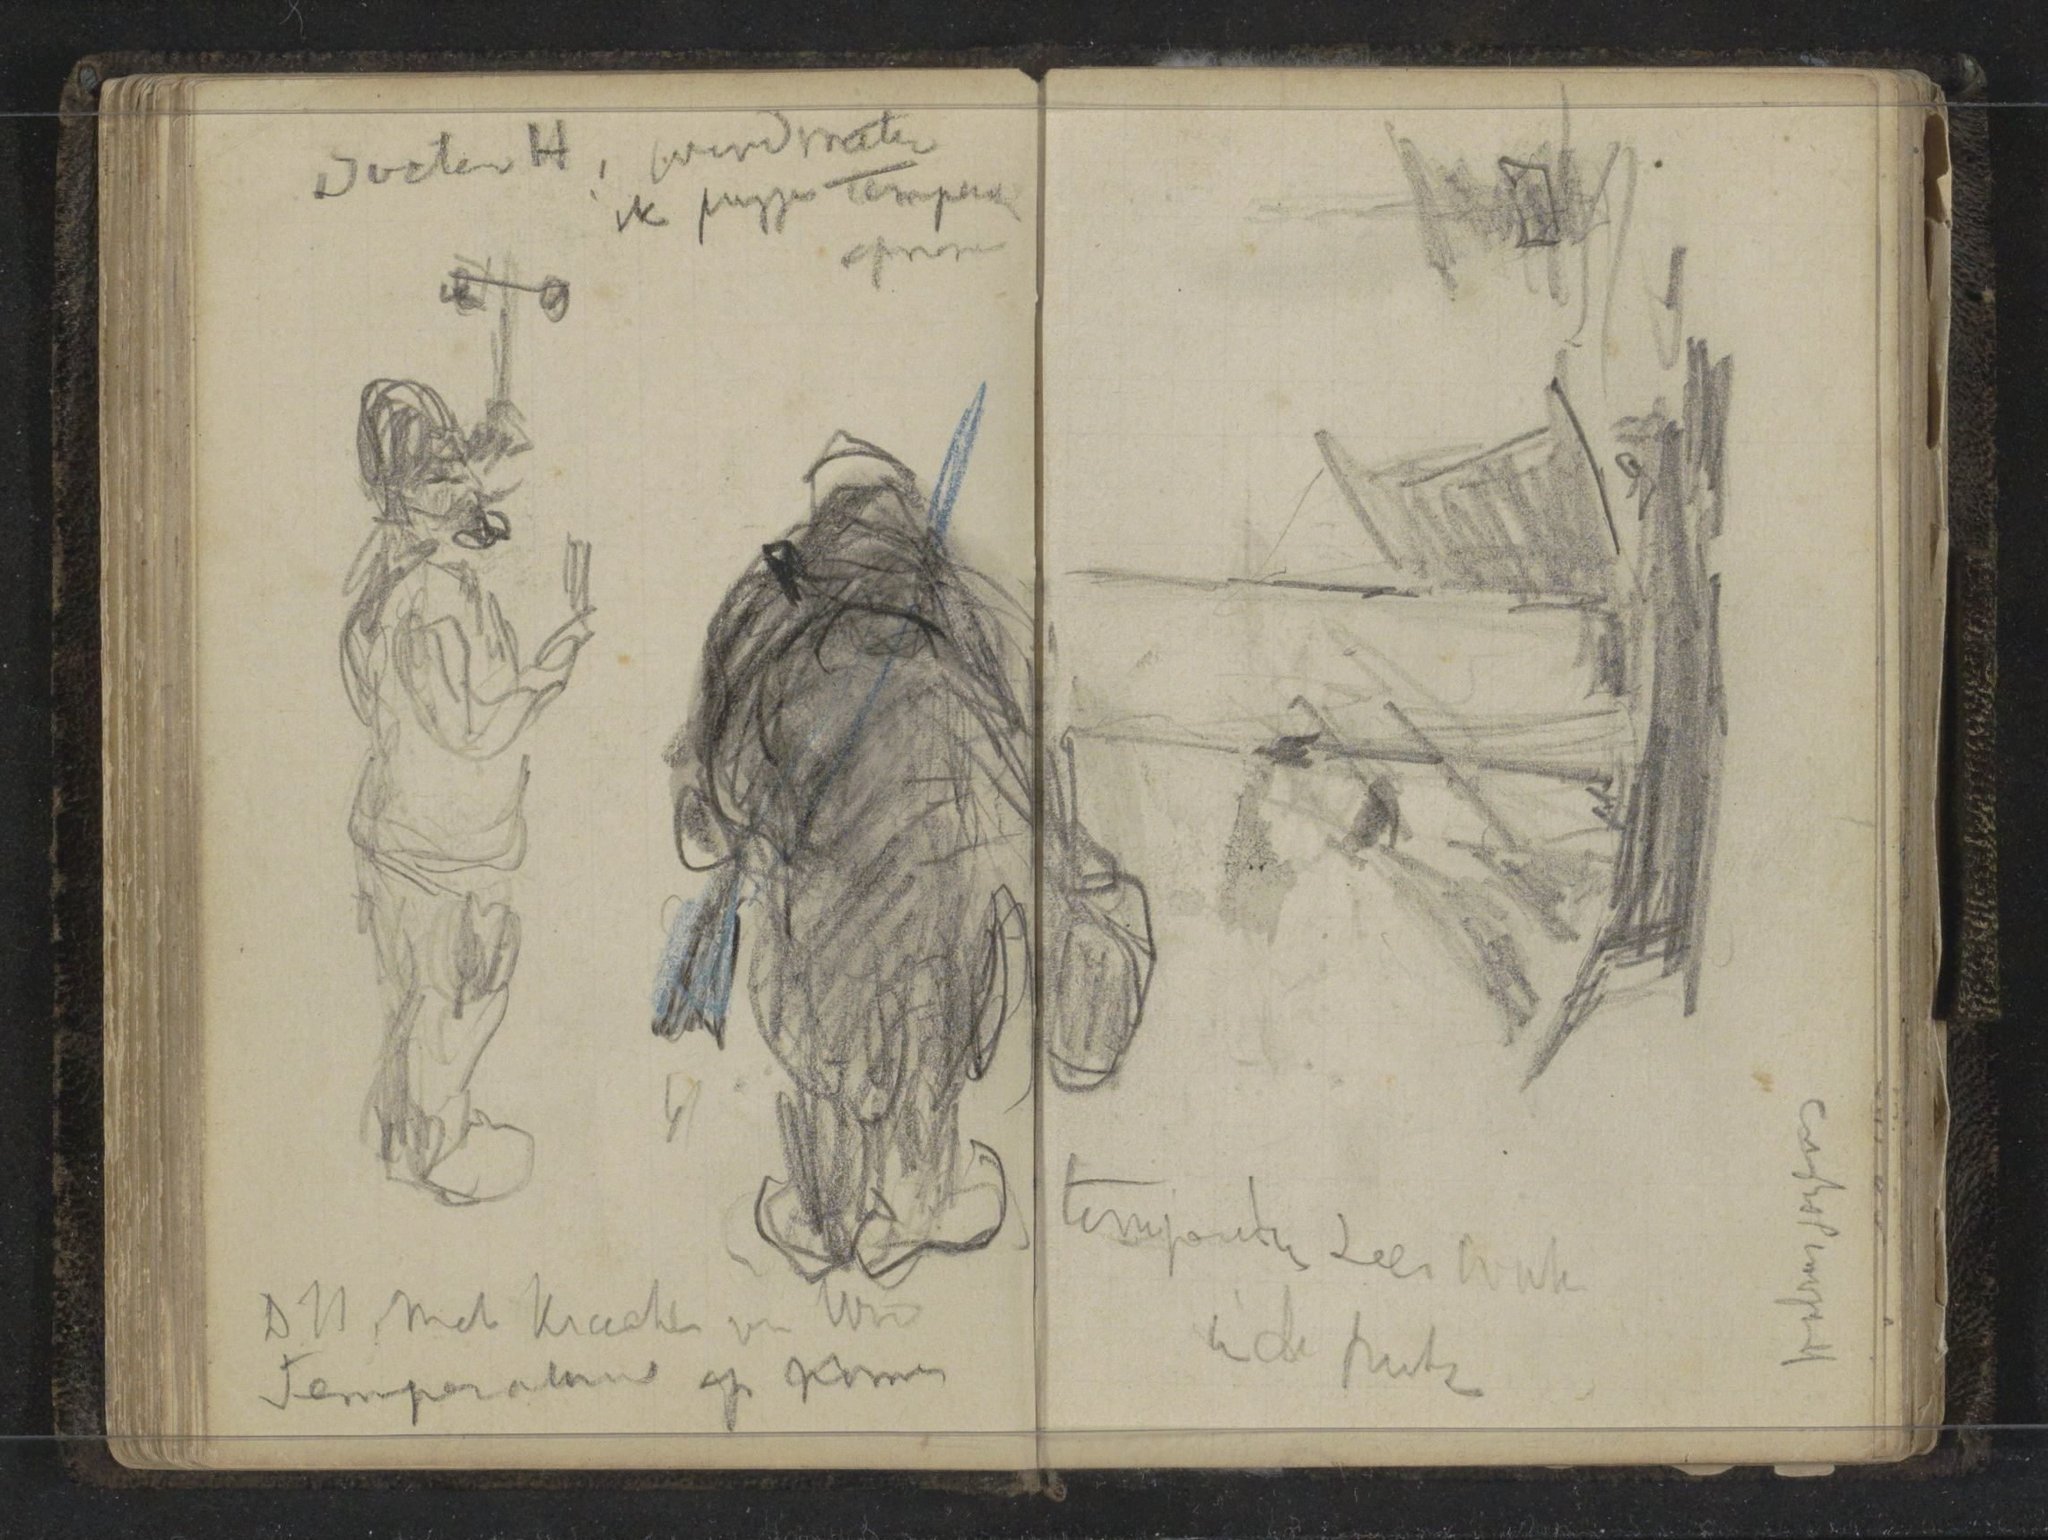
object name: sketchbook leaf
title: Dr. Hamaker tijdens zijn werk en walrusjagers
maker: louis apol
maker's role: draughtsman, painter, print maker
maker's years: 1850-1936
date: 1809-1880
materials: chalk, pencil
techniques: stumping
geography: hammerfest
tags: measuring-instruments (+ scholar, scientist (at work)), sailing-ship, sailing-boat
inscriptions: annotation: ‘Doctor H, windmeter / [...] temperatuur / opnemen / D H meet krachten van wind / temperatuur [...] / walrusjagers’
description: Links is Hamaker in de weer met wind- en temperatuurmeters. Rechts walrusjagers op zee. Blad 46 verso en blad 47 recto uit een schetsboek met 110 bladen betekend tijdens de expeditie naar Nova Zembla in 1880.